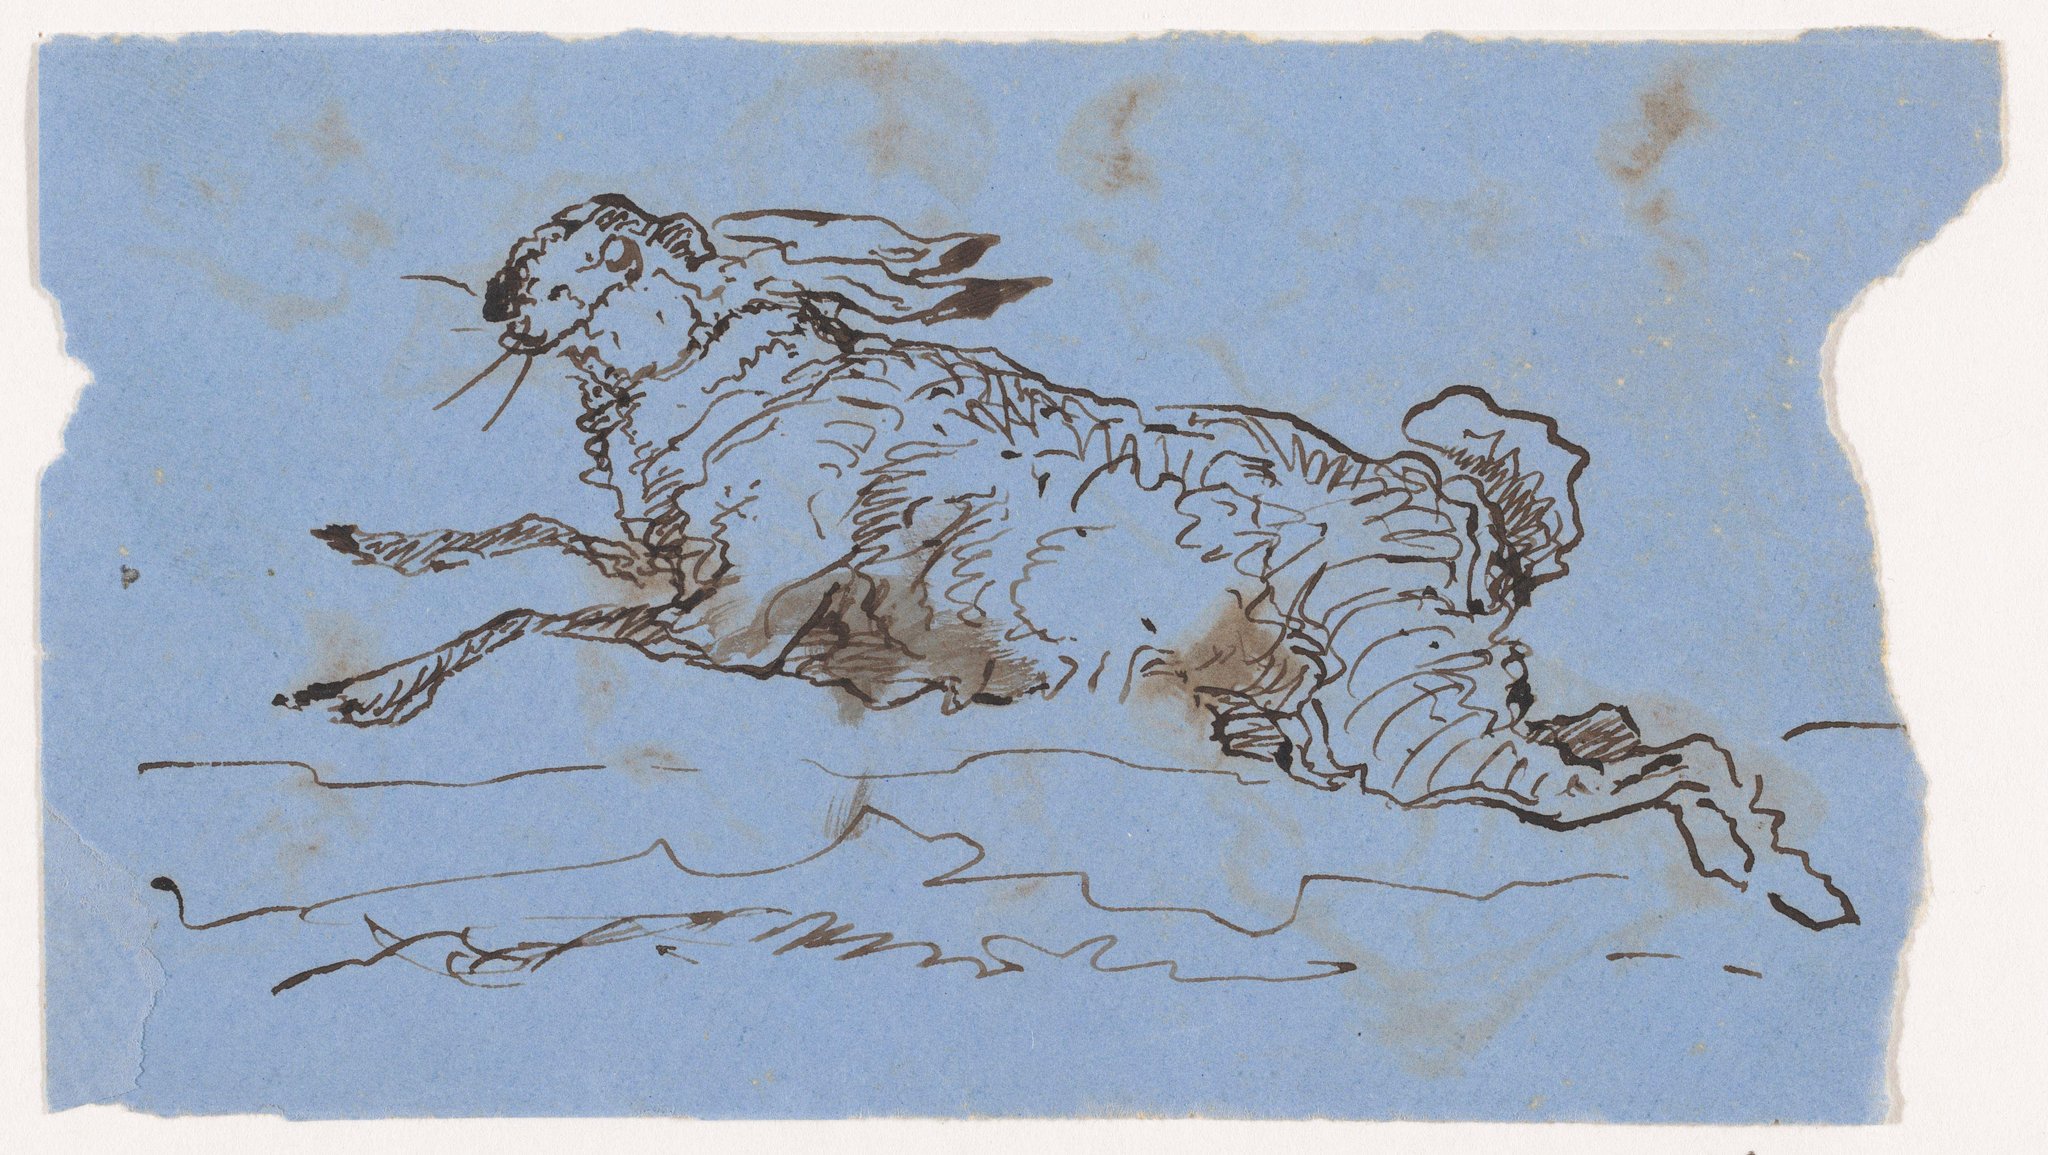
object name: drawing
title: Haas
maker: johannes tavenraat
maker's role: draughtsman, painter, print maker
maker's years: 1809-1881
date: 1840-1880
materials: ink, paper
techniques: pen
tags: rodents: hare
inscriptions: collector's mark: Lugt 2228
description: Haas. Getekend op de achterzijde van een envelop gericht aan J. Tavenraat.